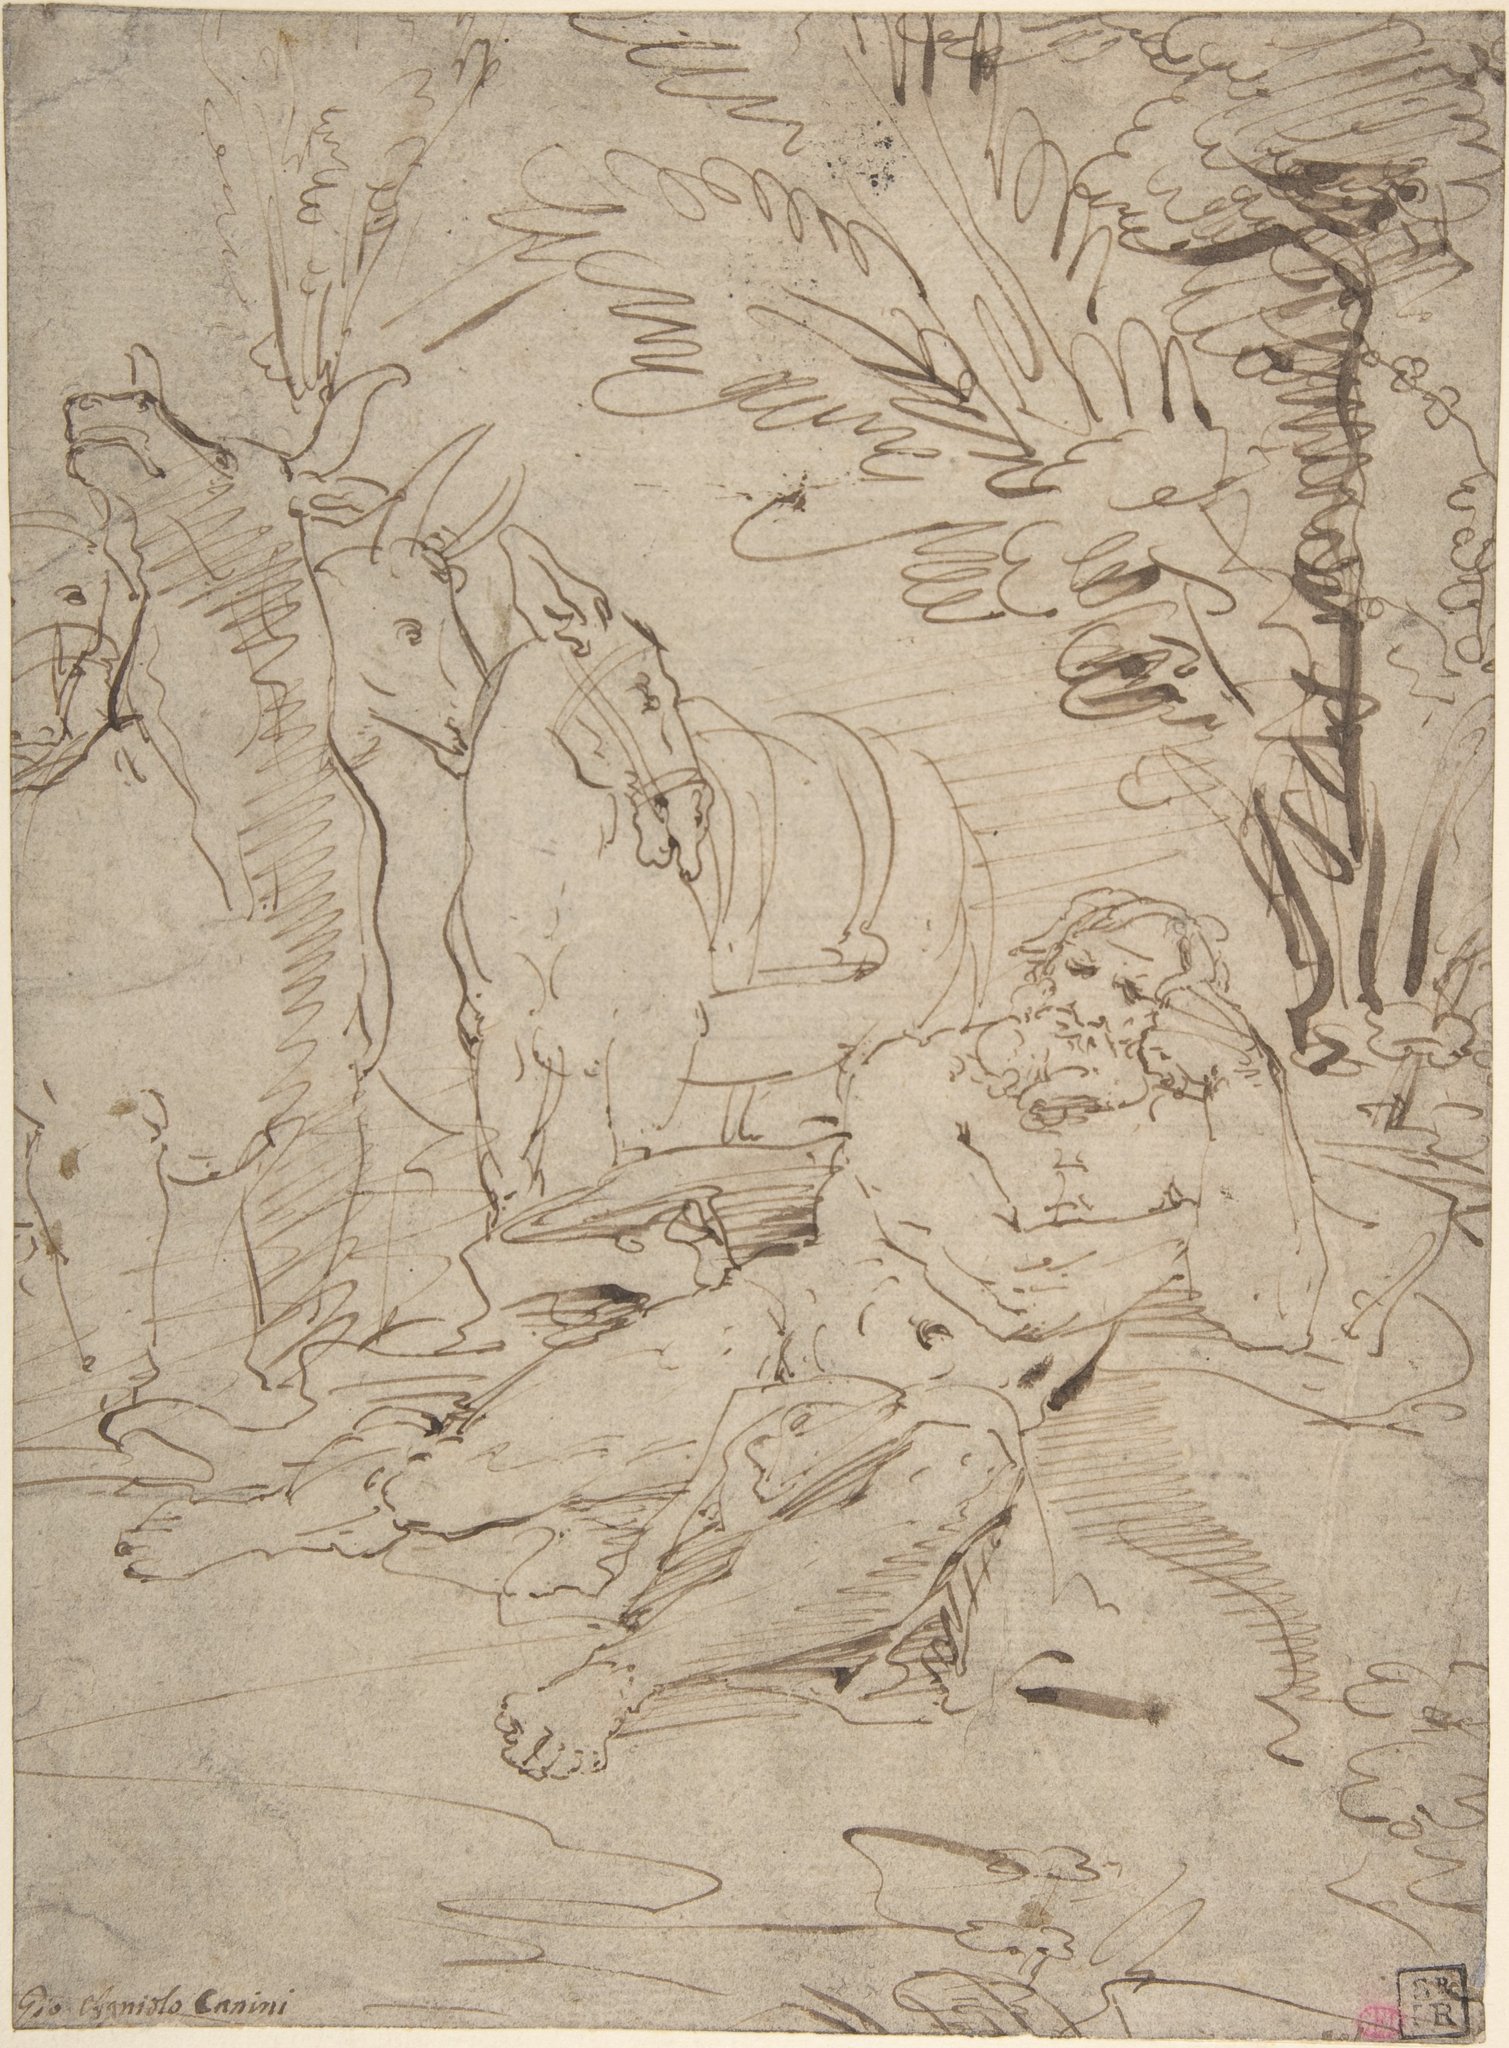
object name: drawing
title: Unidentified Subject: Reclining Nude Male Figure and Cattle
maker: giovanni angelo canini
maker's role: artist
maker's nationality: italian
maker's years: 1609-1666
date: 1615-1666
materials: chalk, ink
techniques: pen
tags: male nudes,cows,horses